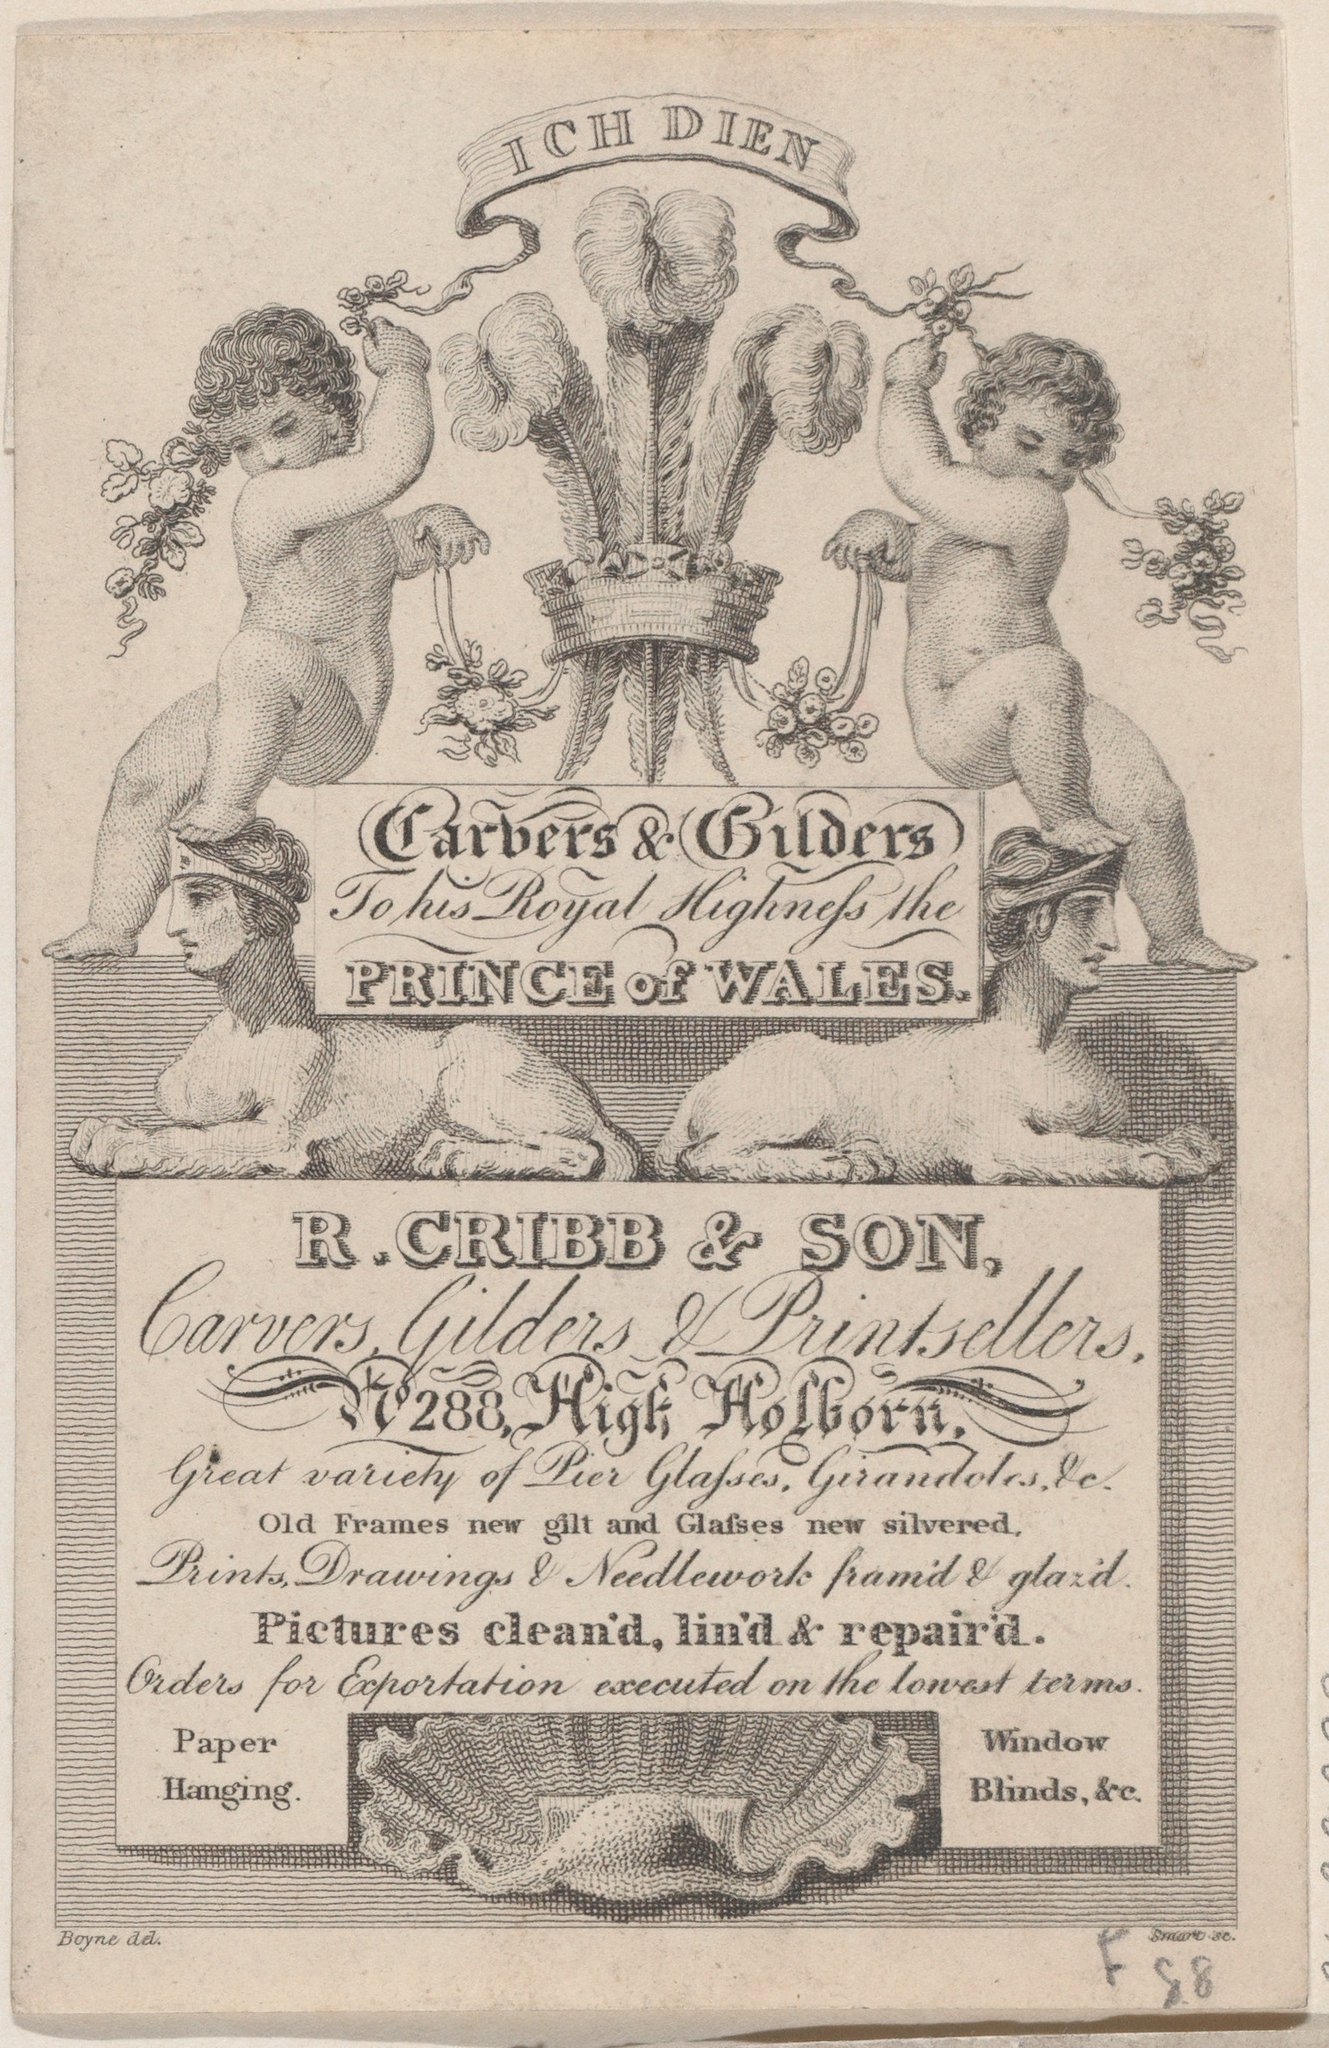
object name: print, trade card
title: Trade card for R Cribb & Son, Publisher and Printmaker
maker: boyne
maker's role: artist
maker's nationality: british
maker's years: 1700-1800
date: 1767-1833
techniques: engraving